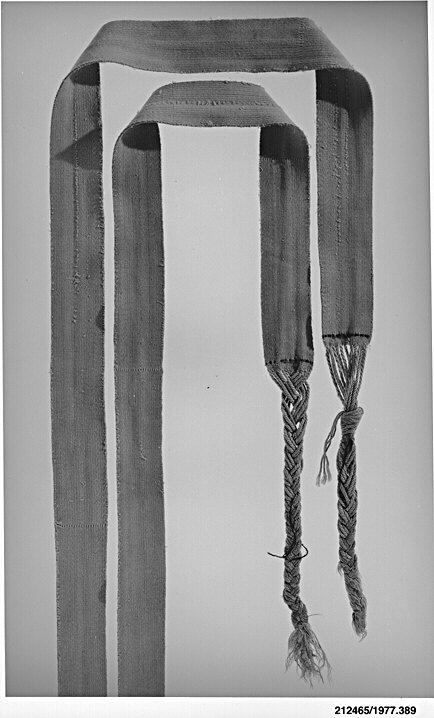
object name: belt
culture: tibetan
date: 1901-1933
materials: silk